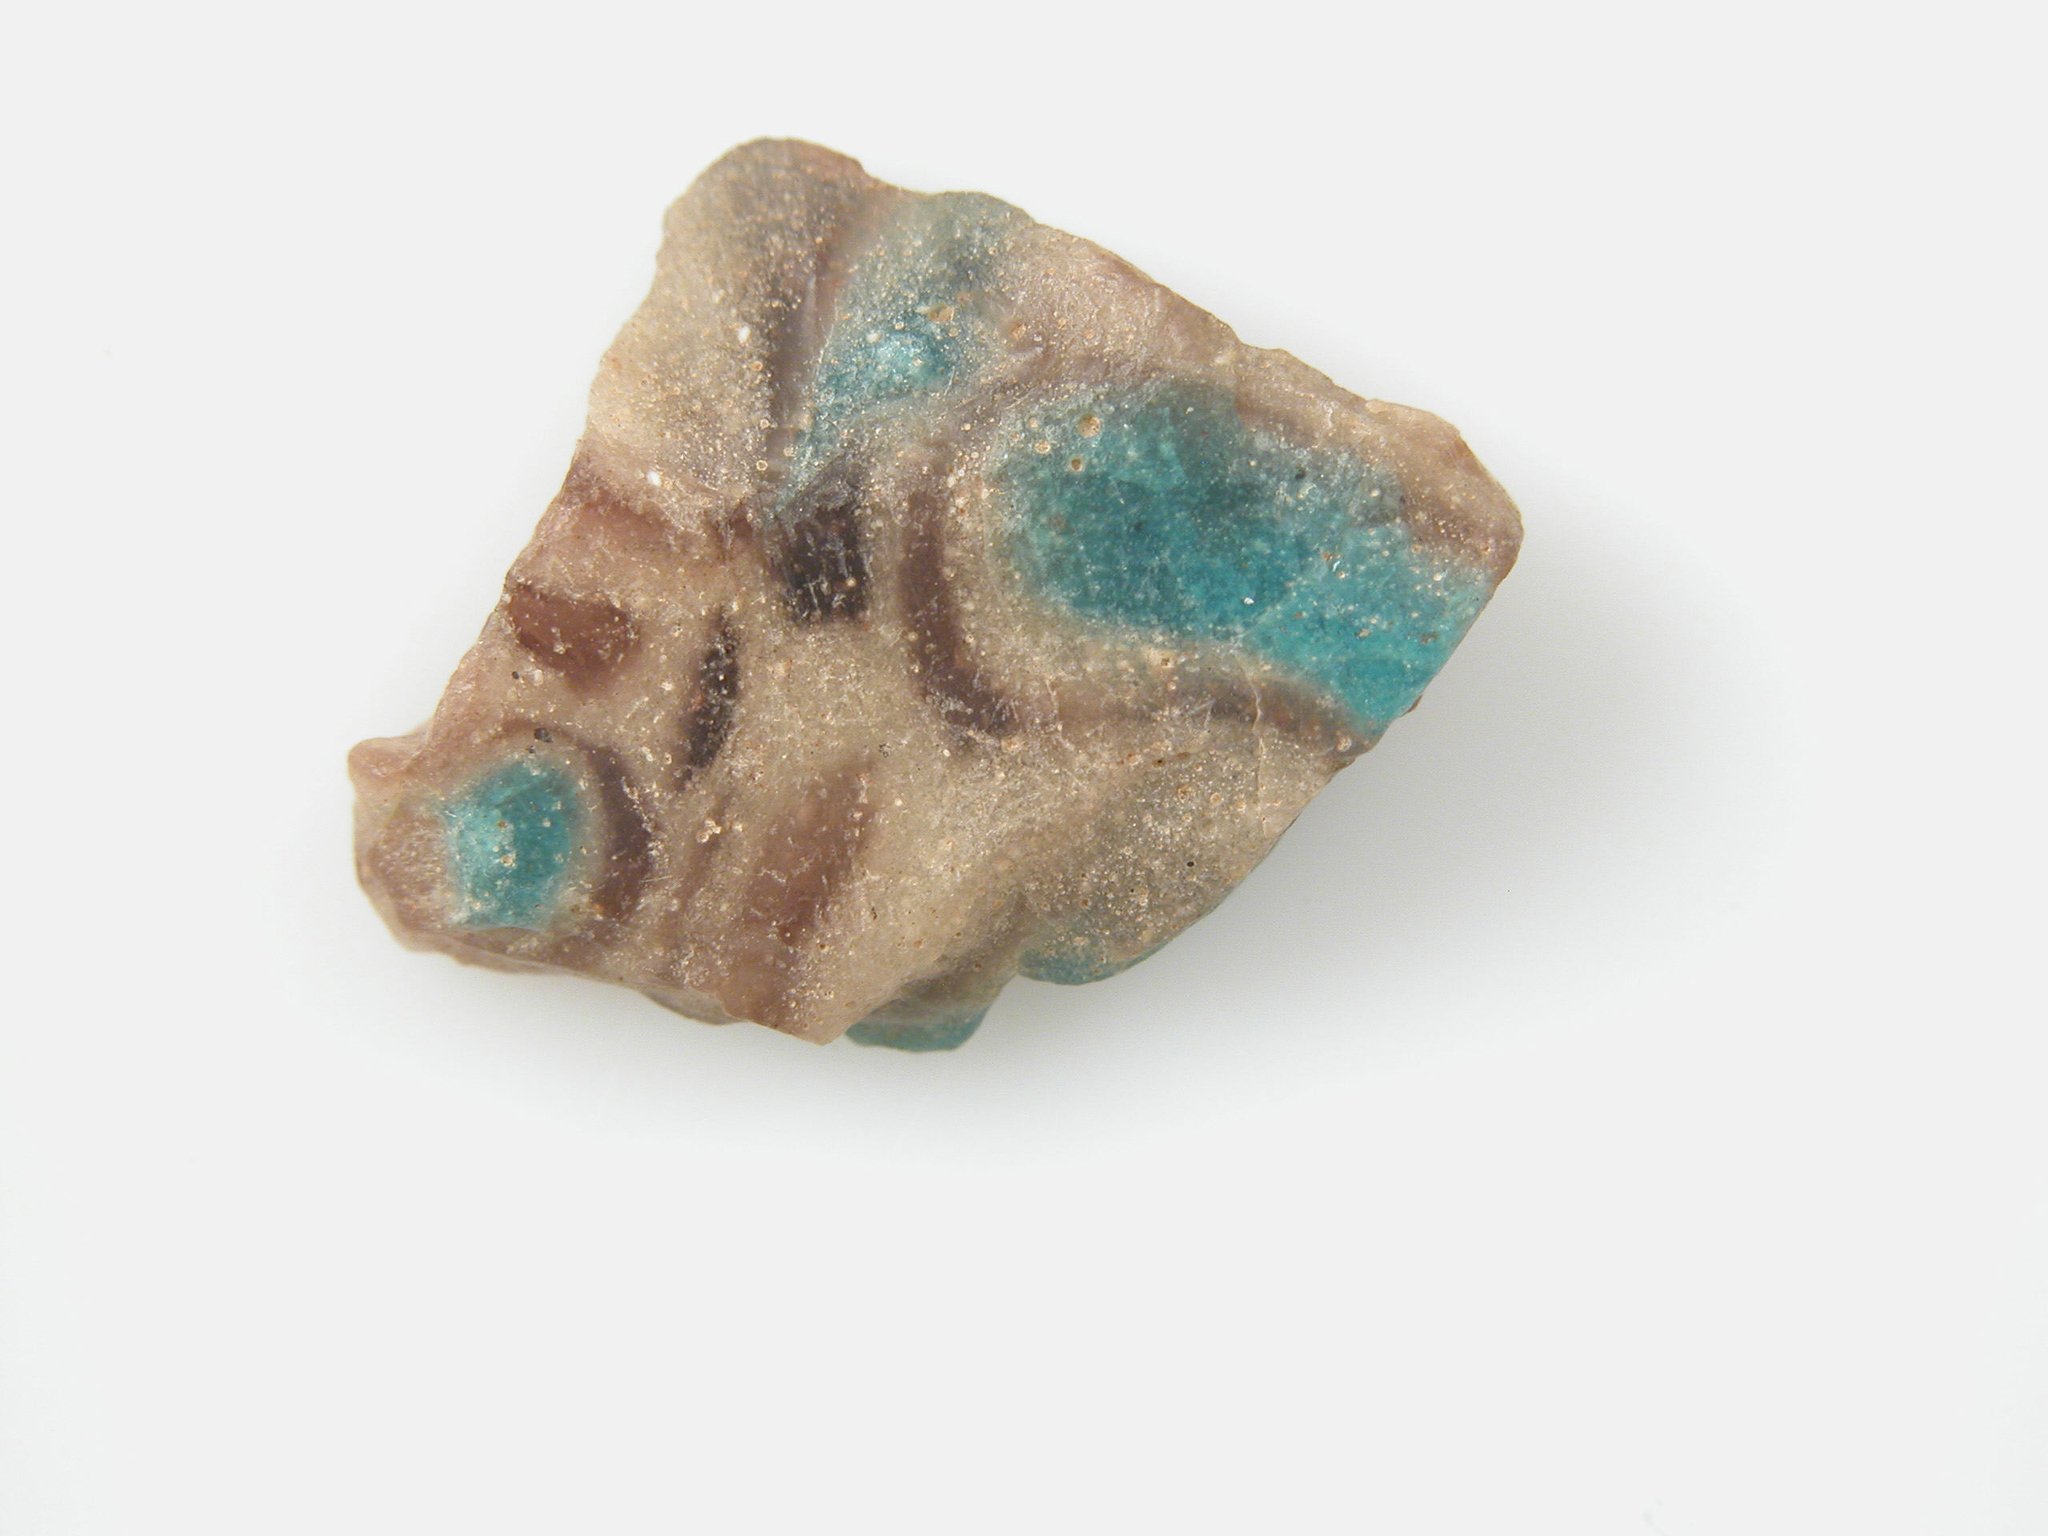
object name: fragment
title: Glass Fragment from a Vessel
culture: coptic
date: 301-433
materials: glass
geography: egypt